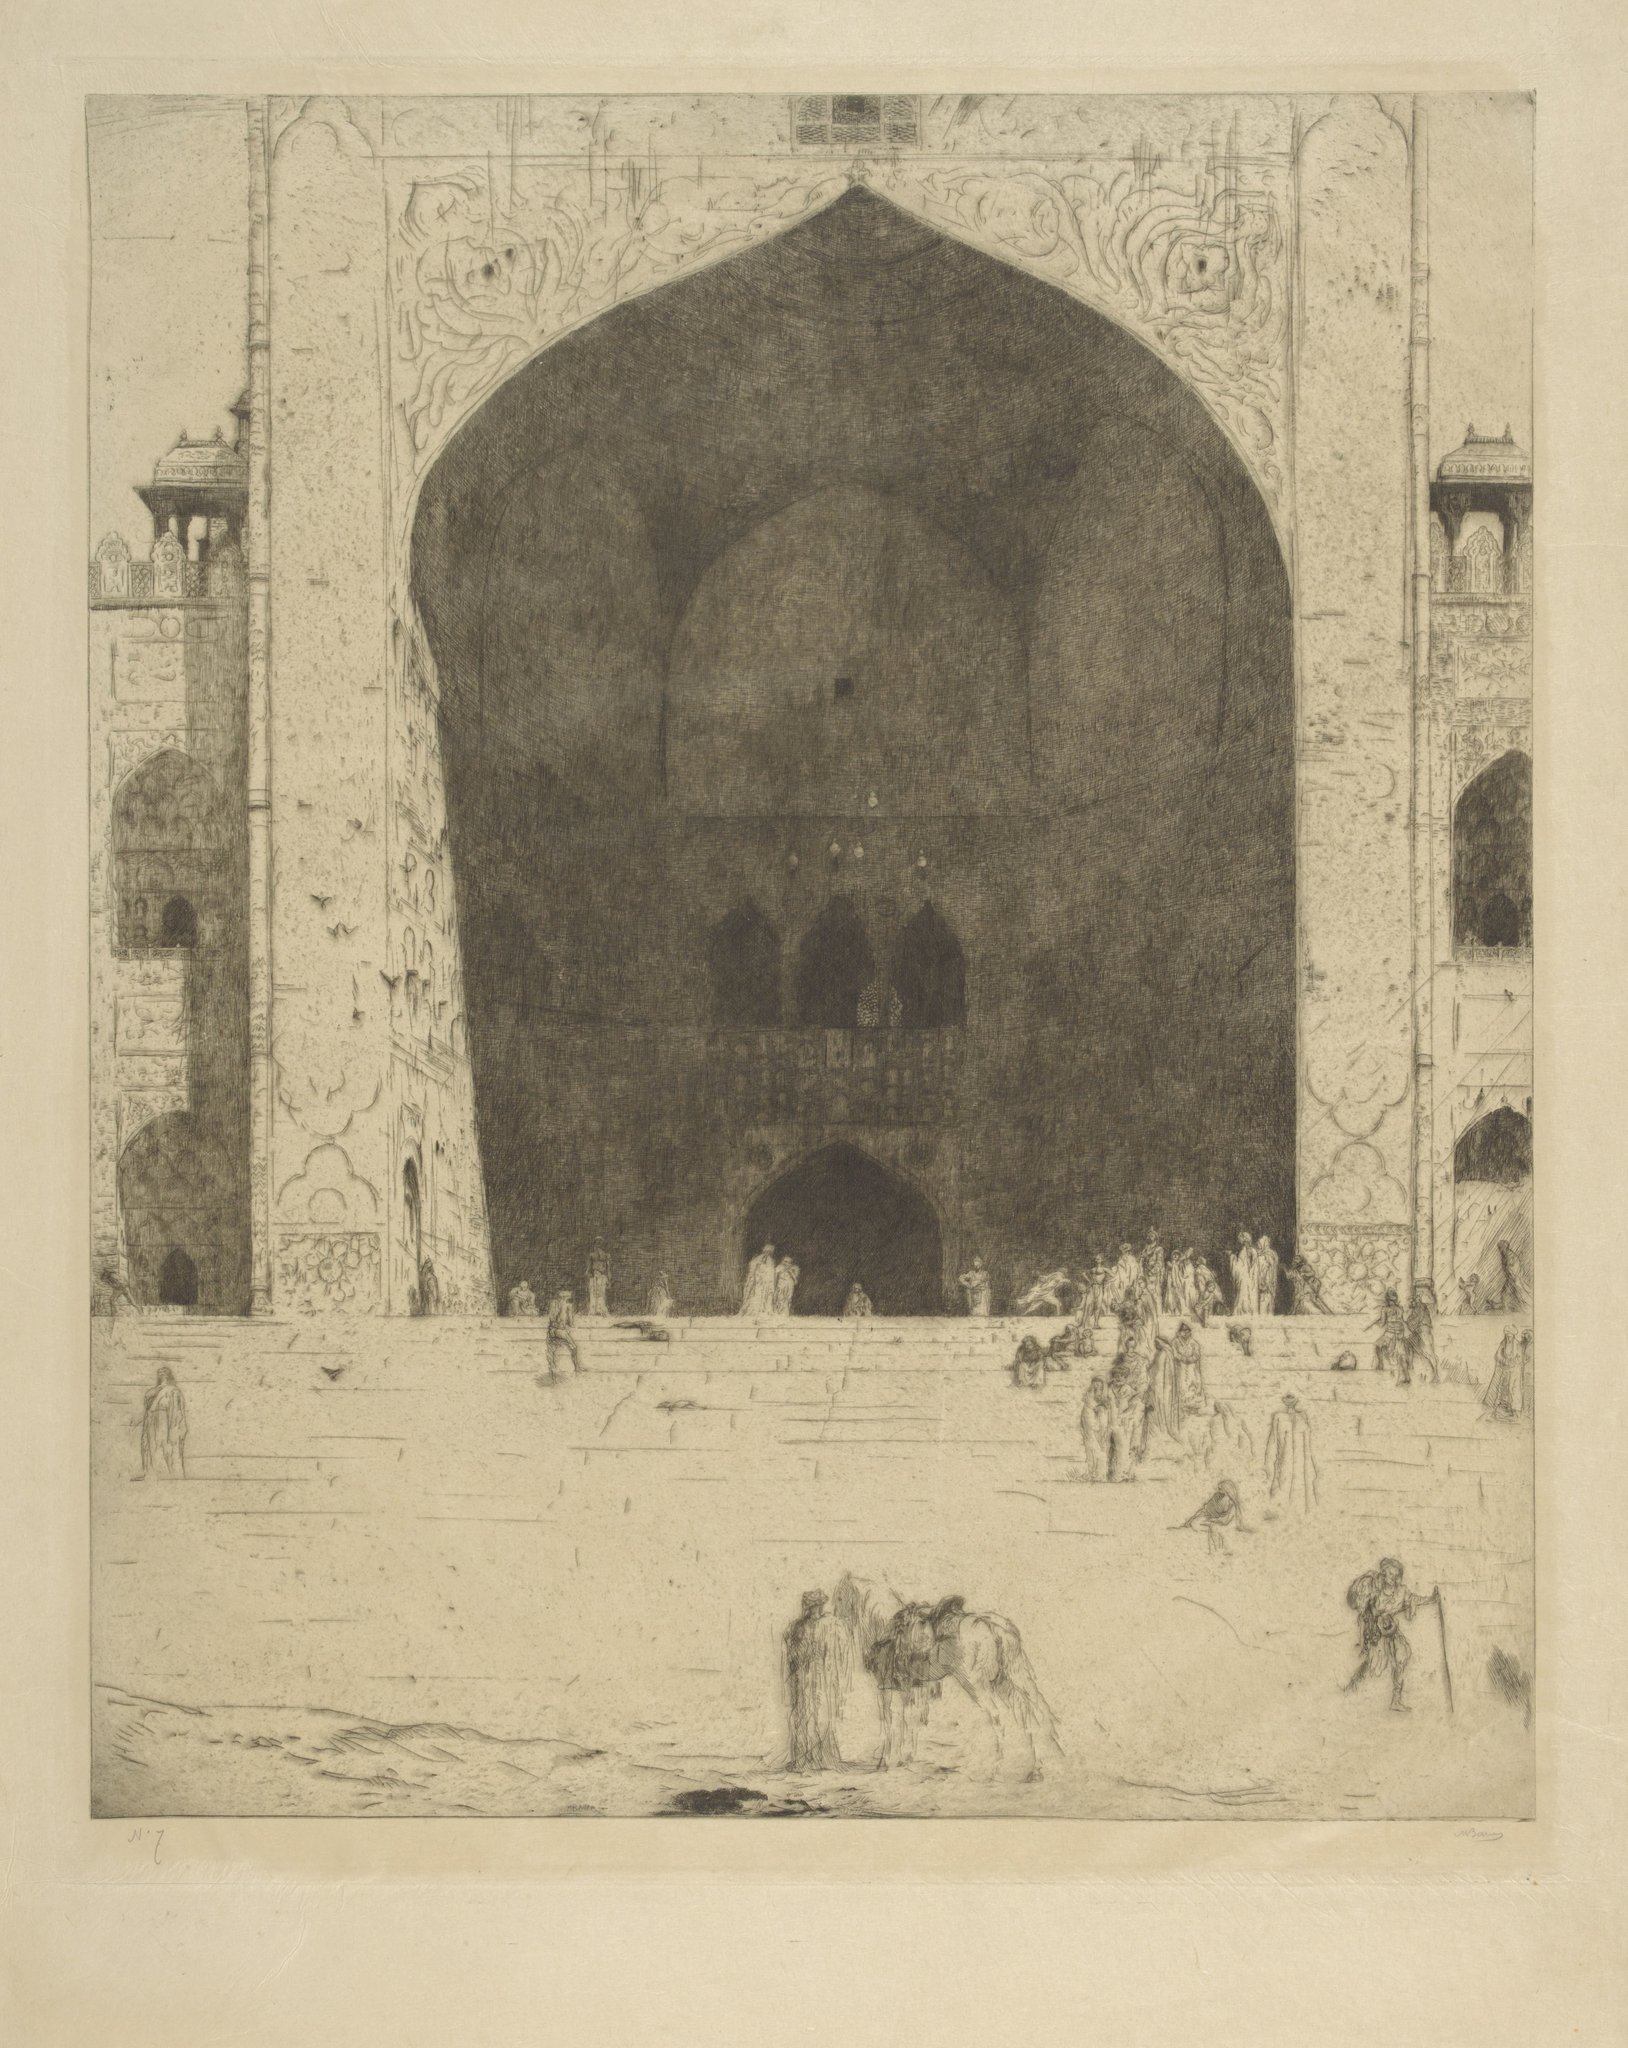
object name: print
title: Gezicht op de ingang van de Jama Masjid in Delhi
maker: marius bauer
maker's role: draughtsman, print maker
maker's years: 1867-1932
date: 1899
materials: paper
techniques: etching, intaglio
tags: temple, shrine ~ islam, mohammedanism, leading a horse by the reins; rider beside his horse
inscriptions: collector's mark: Lugt 2228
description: Voor de trappen staat een man met een paard aan de teugels. Op de trappen staan en zitten mensen.